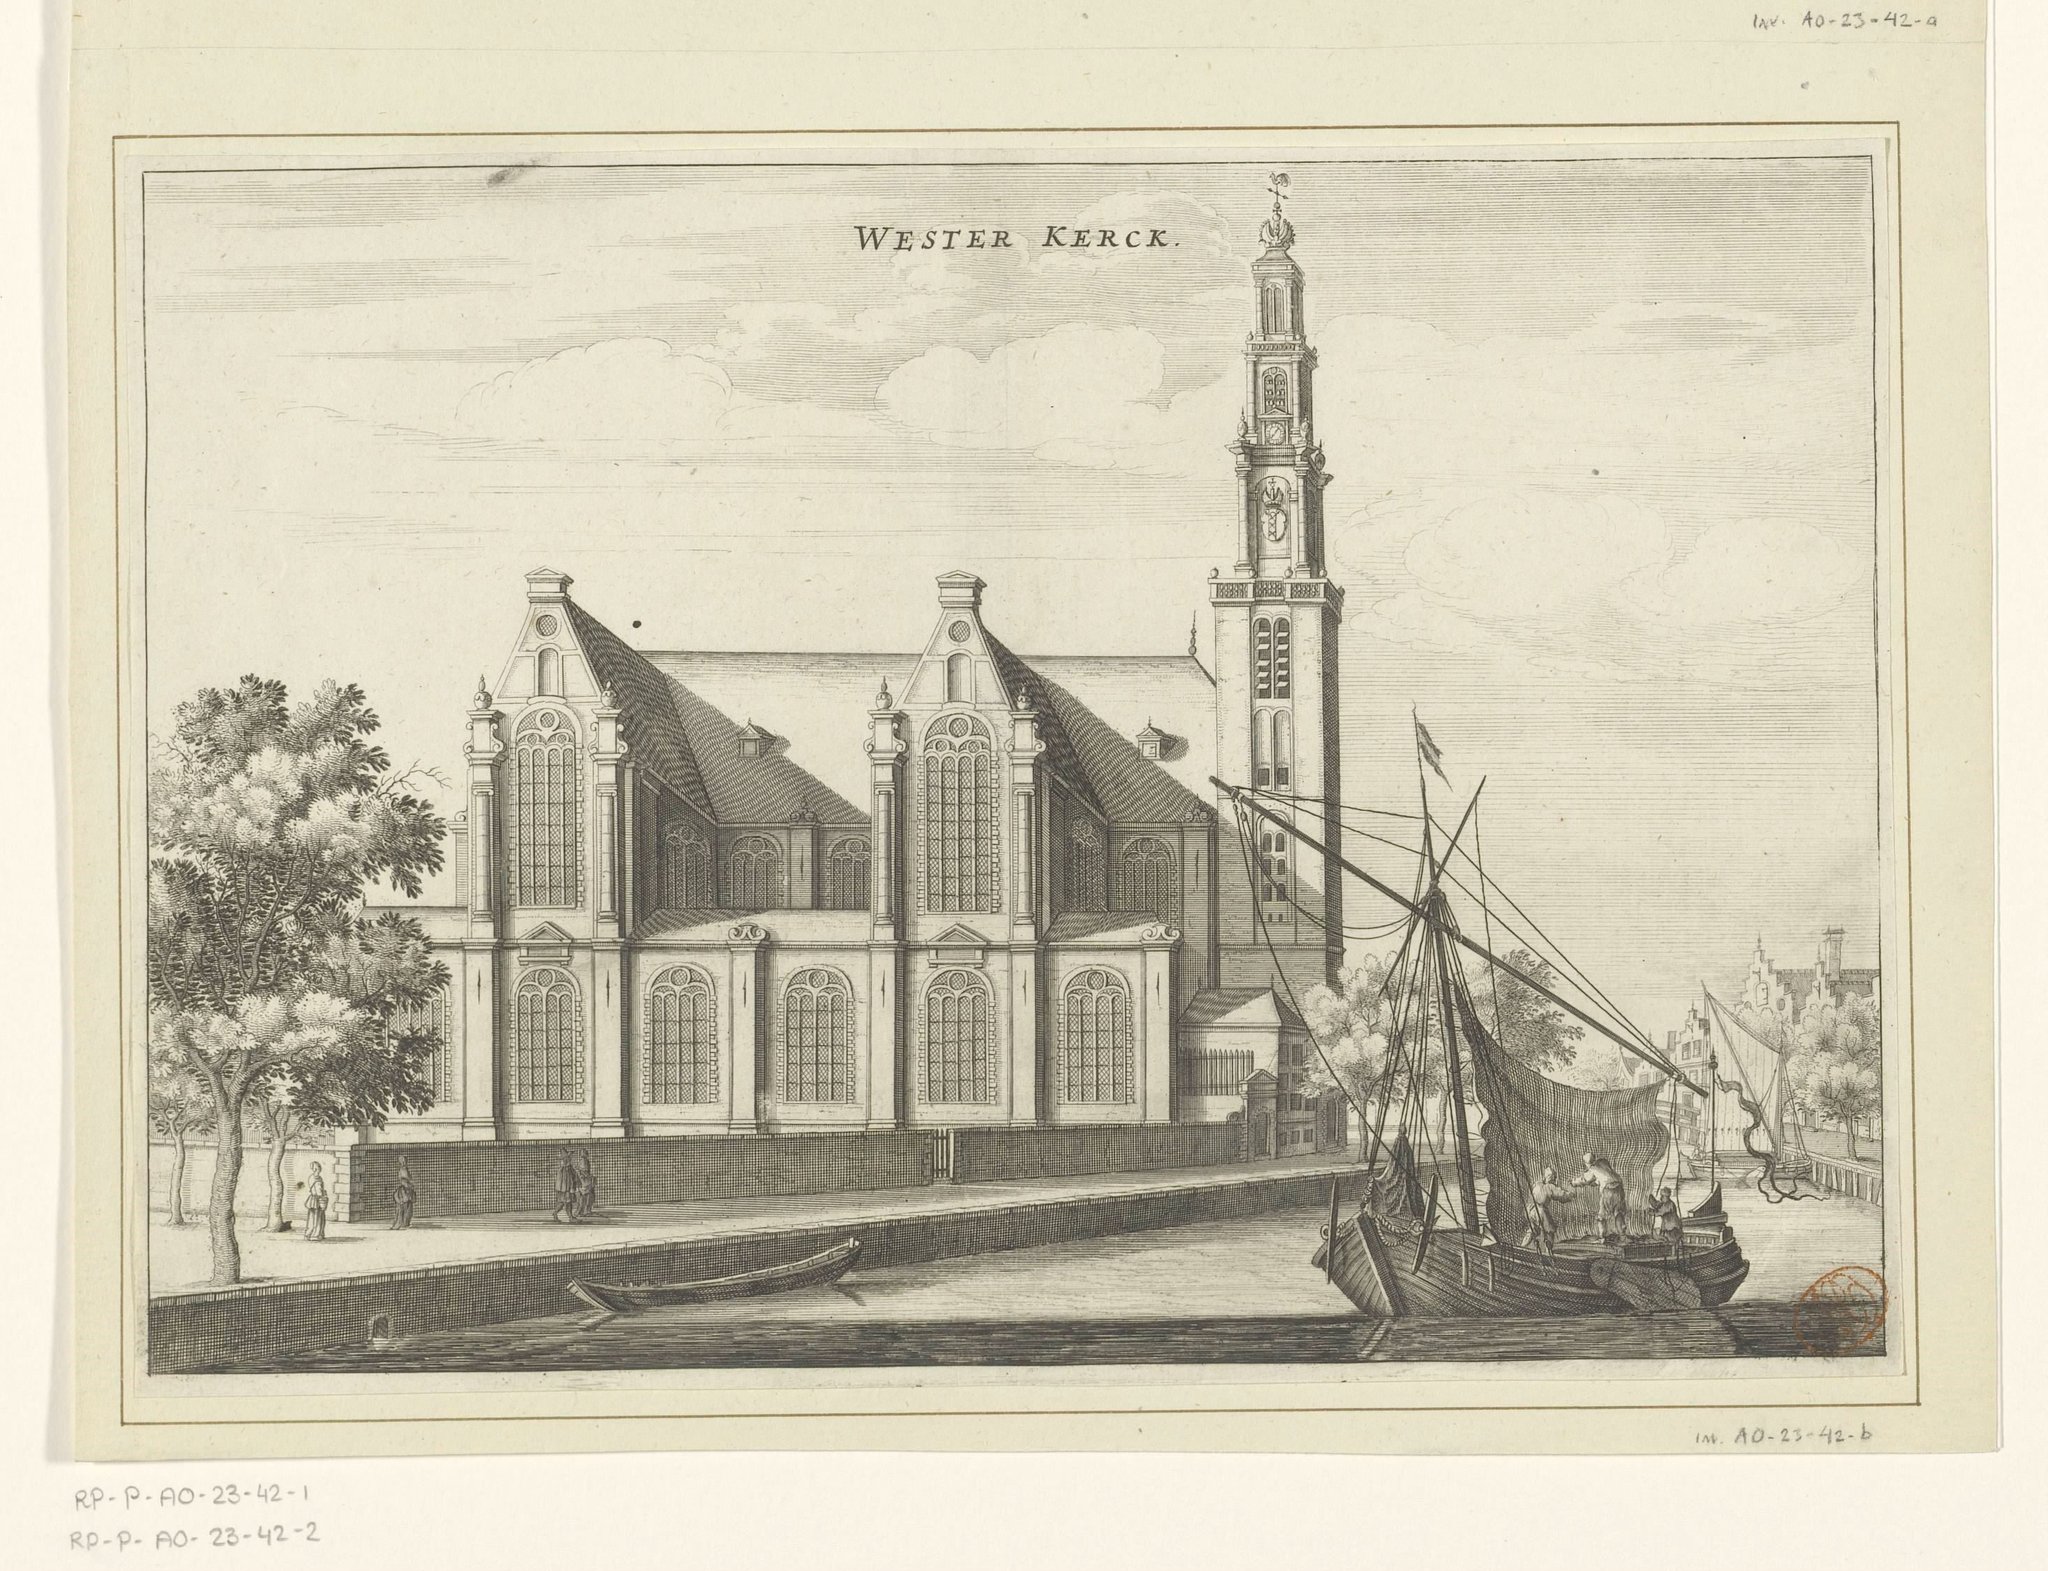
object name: book illustration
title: Gezicht op de Westerkerk te Amsterdam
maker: jacob van meurs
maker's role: draughtsman, print maker, publisher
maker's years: 1619-1680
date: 1663-1664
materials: paper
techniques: engraving, etching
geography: amsterdam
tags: sailing-ship, sailing-boat, church (exterior), rowing-boat, canoe, etc., canals, waters (in city)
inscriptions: collector's mark: Lugt 195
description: Huidige staat van prent ook gebruikt in: Dapper, Olfert. Historische beschryving der stadt Amsterdam: waer in de voornaemste geschiedenissen (na een kort verhael van gansch Hollant en d'omleggende dorpen (…). Amsterdam: Jacob van Meurs, 1663.* En in: Zesen, Philipp von. Beschreibung der Stadt Amsterdam: darinnen von derselben ersten Ursprunge bis auf gegenwärtigen Zustand (…). Amsterdam: Joachim Nosche, 1664. * In sommige exemplaren van deze uitgave komt de huidige staat van de prent voor. In andere exemplaren is een latere staat ingebonden, waarop boven de Nederlandse een Franse titel is toegevoegd.